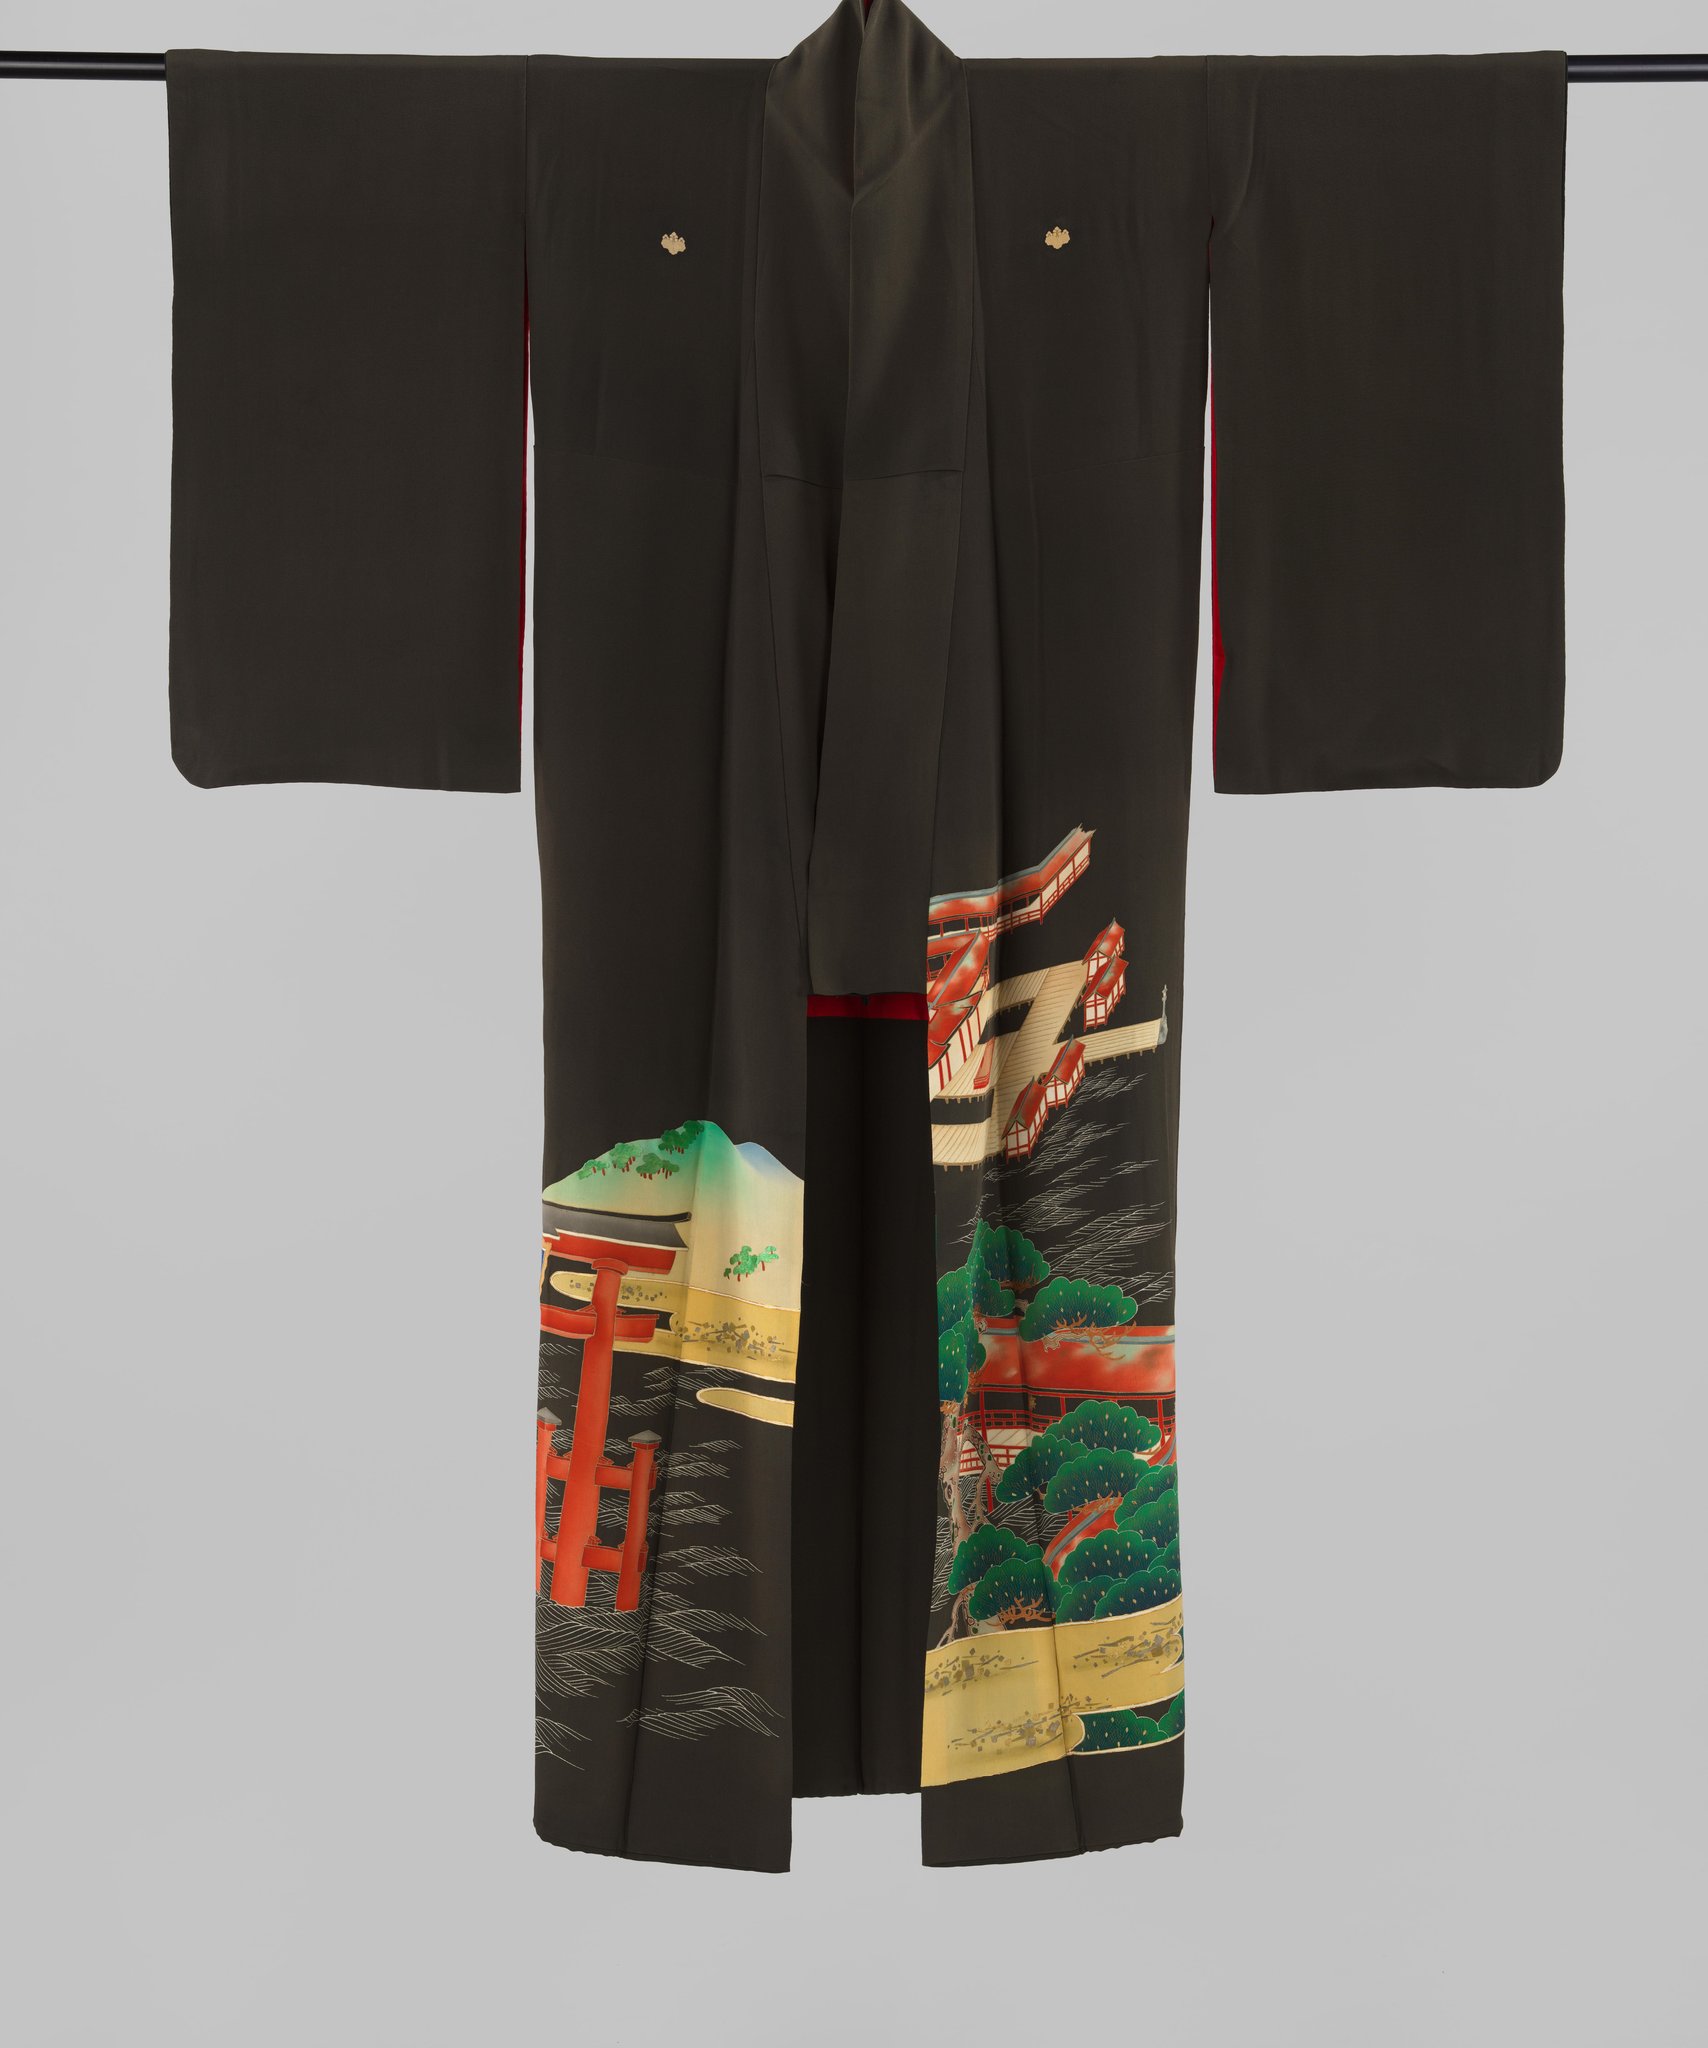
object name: kimono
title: Kimono with a view of the Itsukushima Shrine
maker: Anonymous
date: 1920-1940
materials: silk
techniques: embroidered, painting, weave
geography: japan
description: Formele zwarte vrouwenkimono (kuro-tomesode), met op de benedenkant een versiering van de Itsukushima-schrijn: een gebouw en poort (torii) in water aan een kust met pijnbomen en stenen lantaarns, doorbroken door wolkenbanden. Zwarte crêpe zijde (chirimen) met geschilderde yuzen versiering in verschillende tinten rood, oranje, groen en bruin, met geborduurde detaillering in de pijnbomen. Voering van rode zijde. Vijf familiewapens (mon) van pauwlonia.